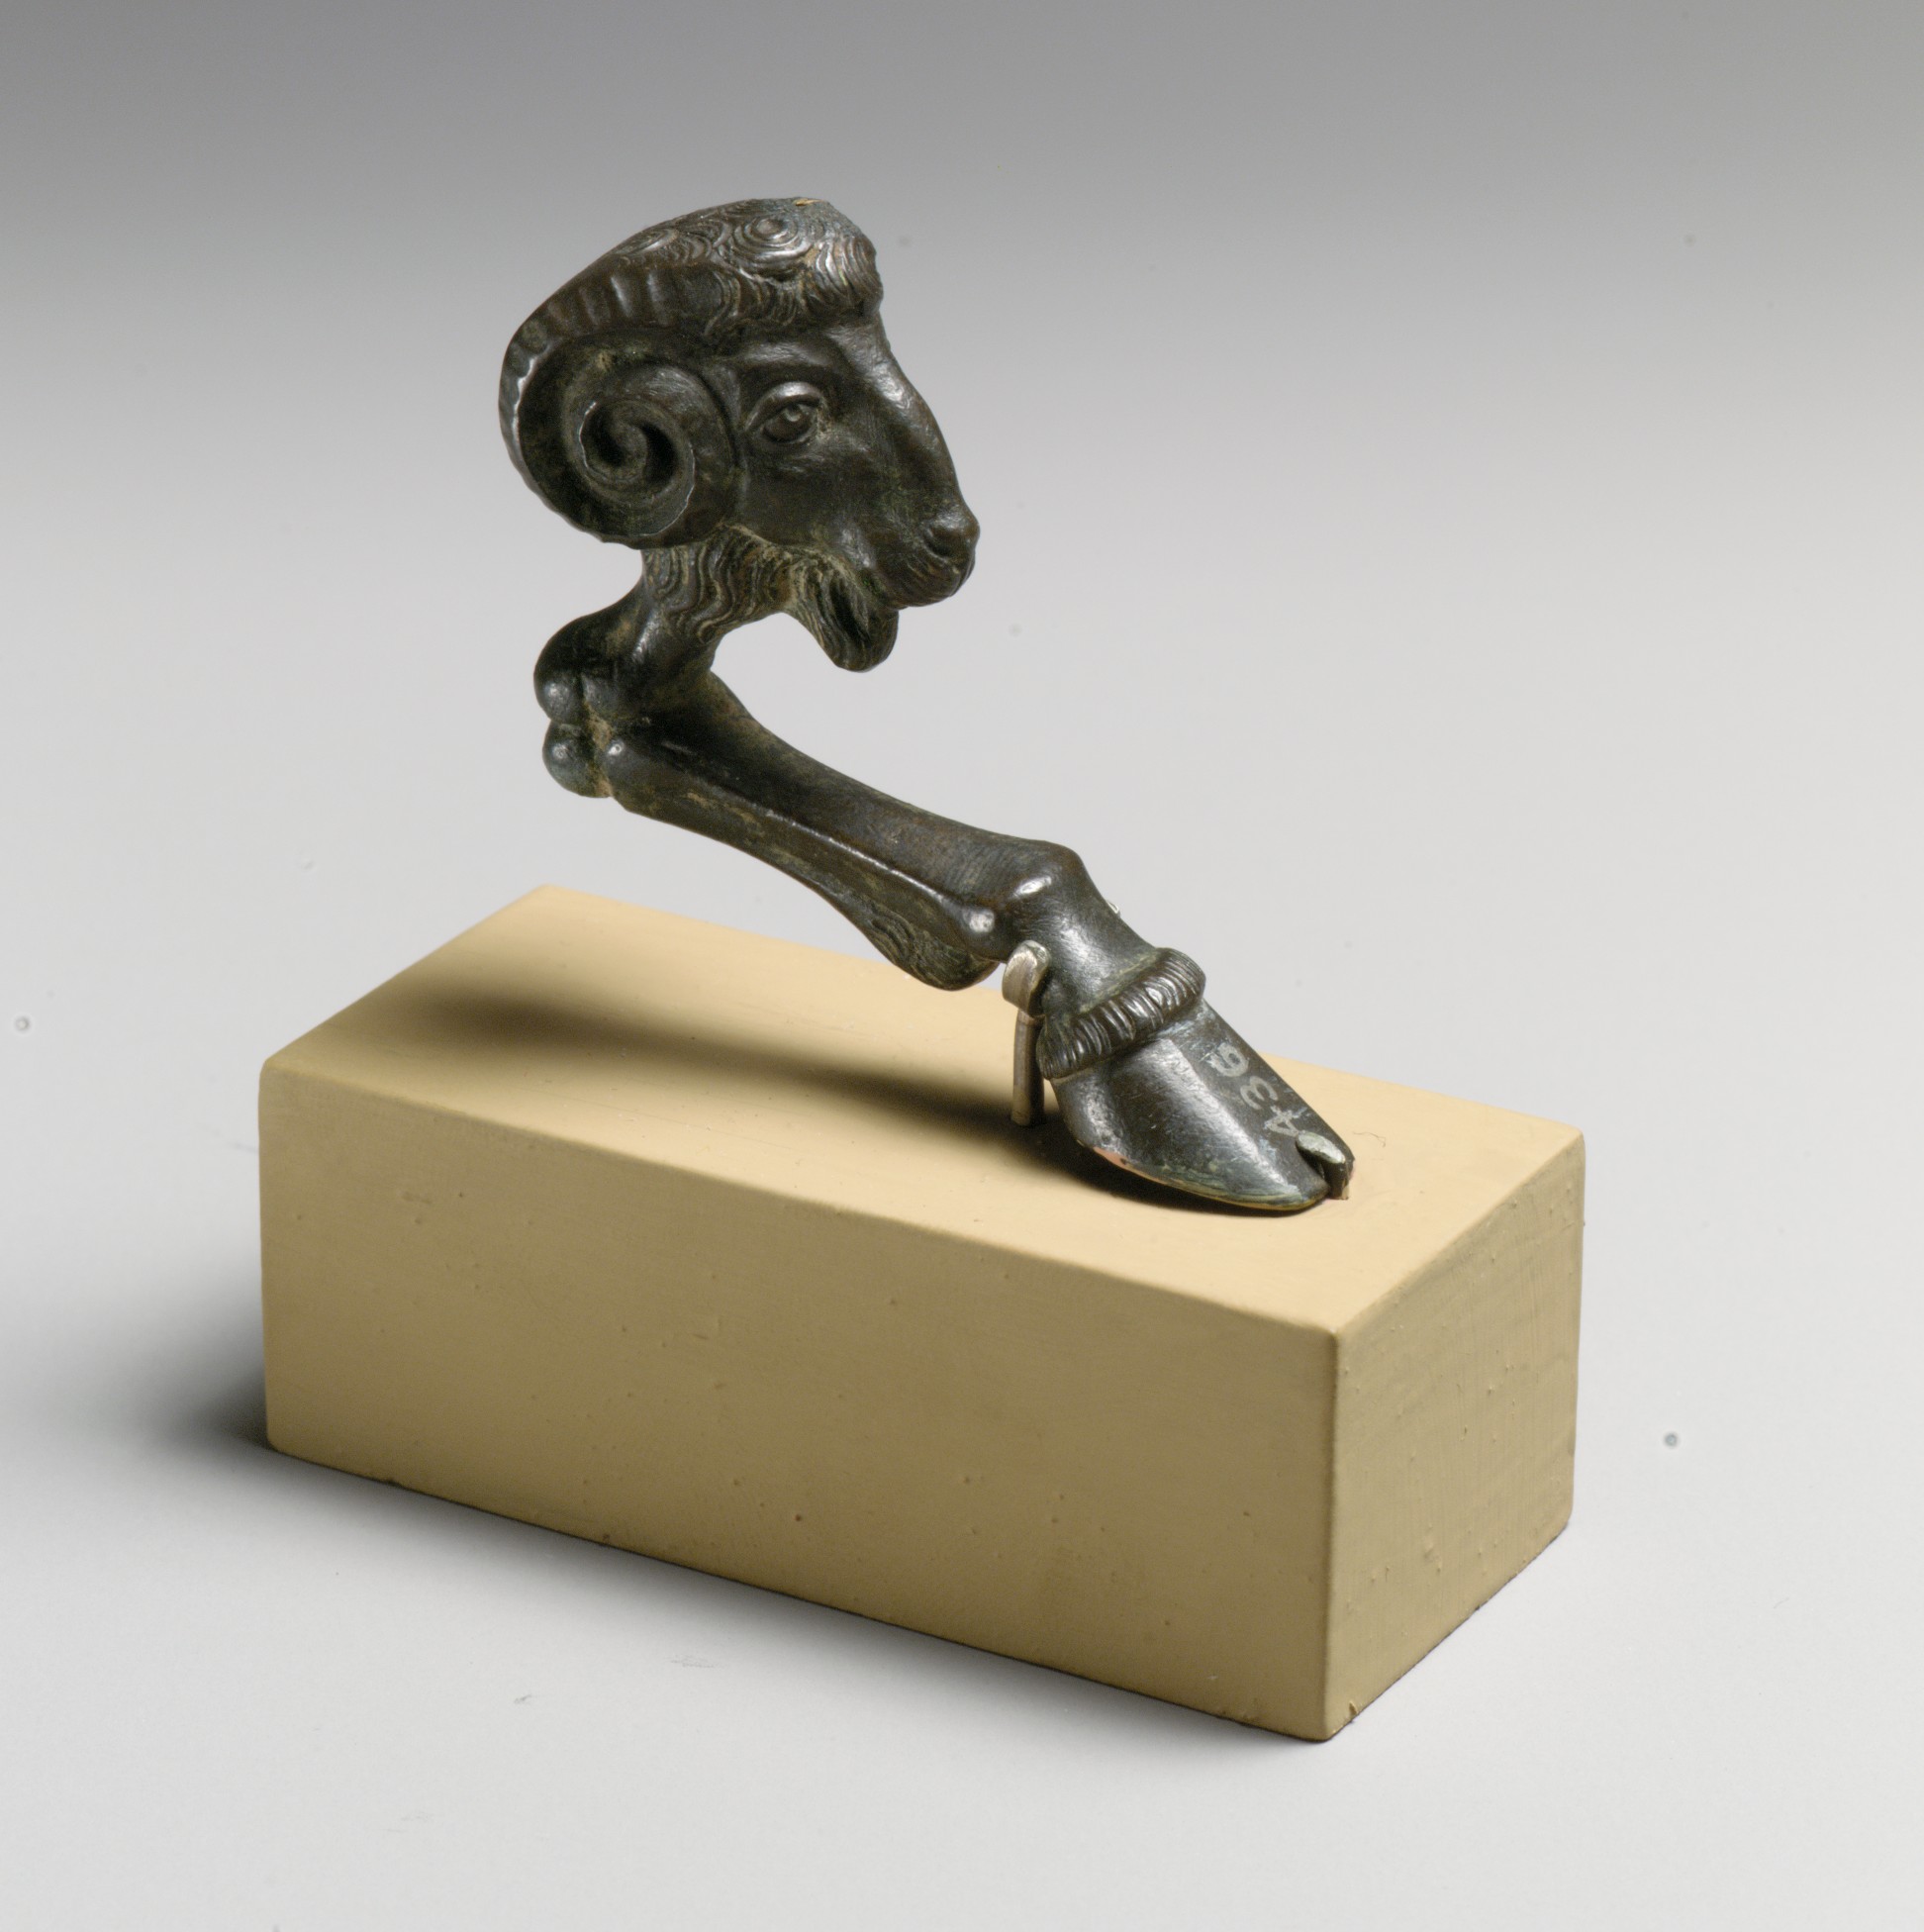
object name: support in the form of a ram's head and foreleg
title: Bronze support in the form of a ram's head and foreleg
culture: roman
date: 100 BCE-100 CE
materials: bronze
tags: rams